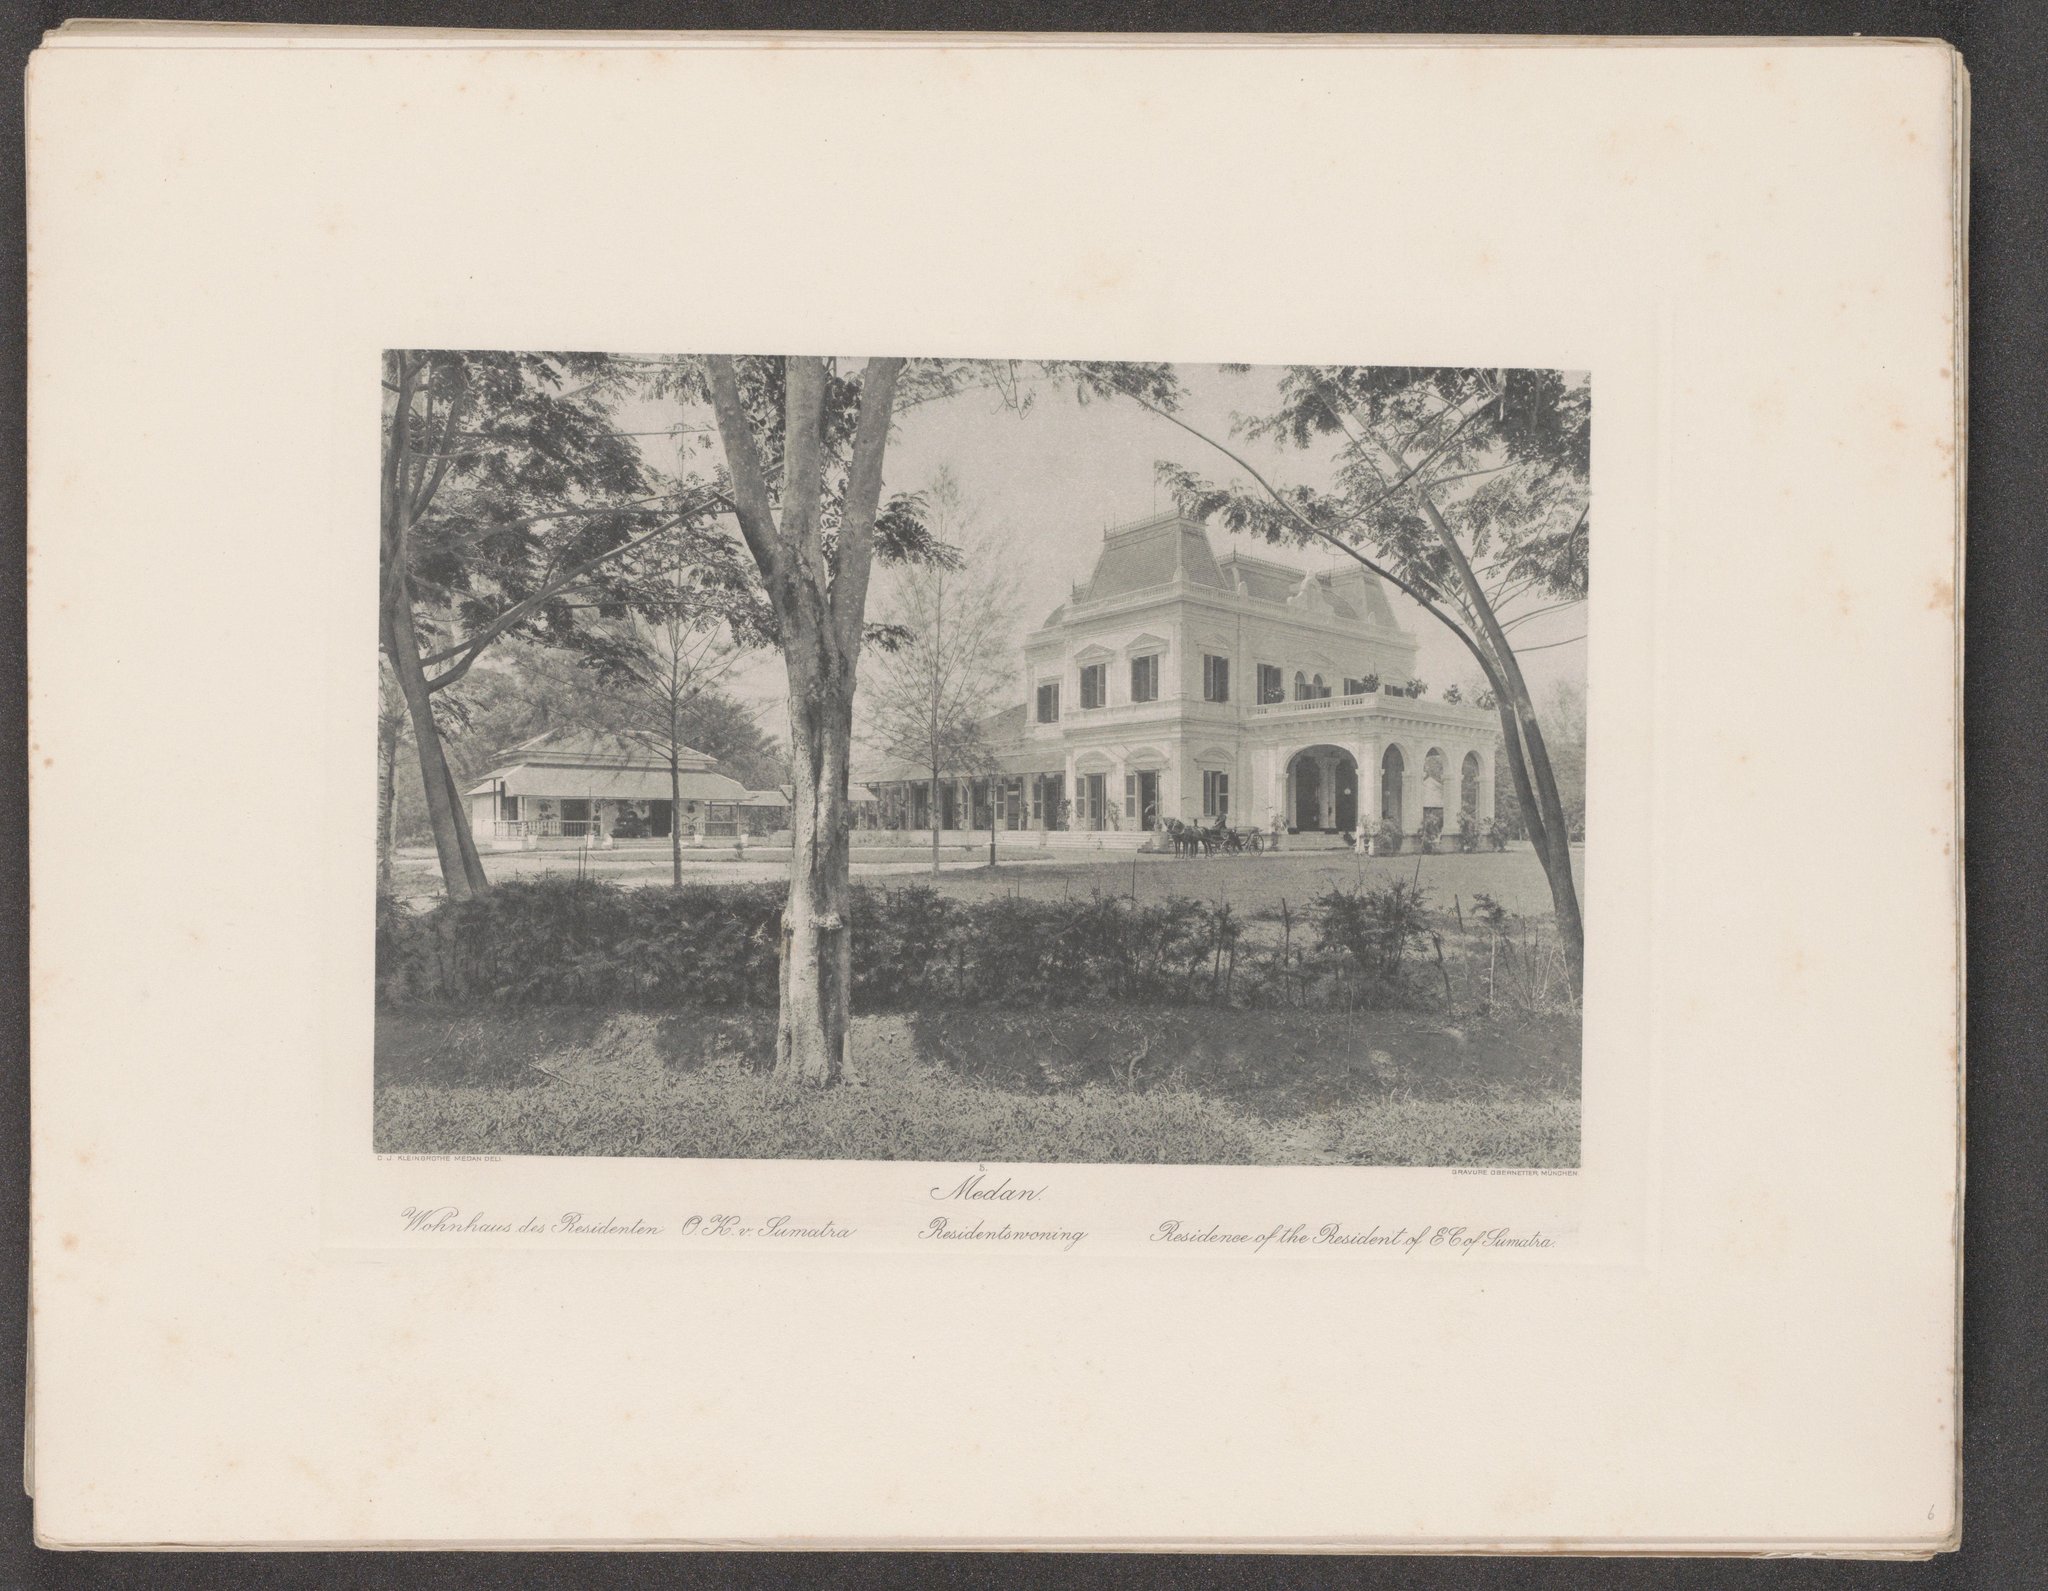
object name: photomechanical print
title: Medan. Residentswoning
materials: paper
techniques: photoaquatint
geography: medan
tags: villa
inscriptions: number: ‘5’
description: Onderdeel van Album met heliogravures van Sumatra's oostkust.